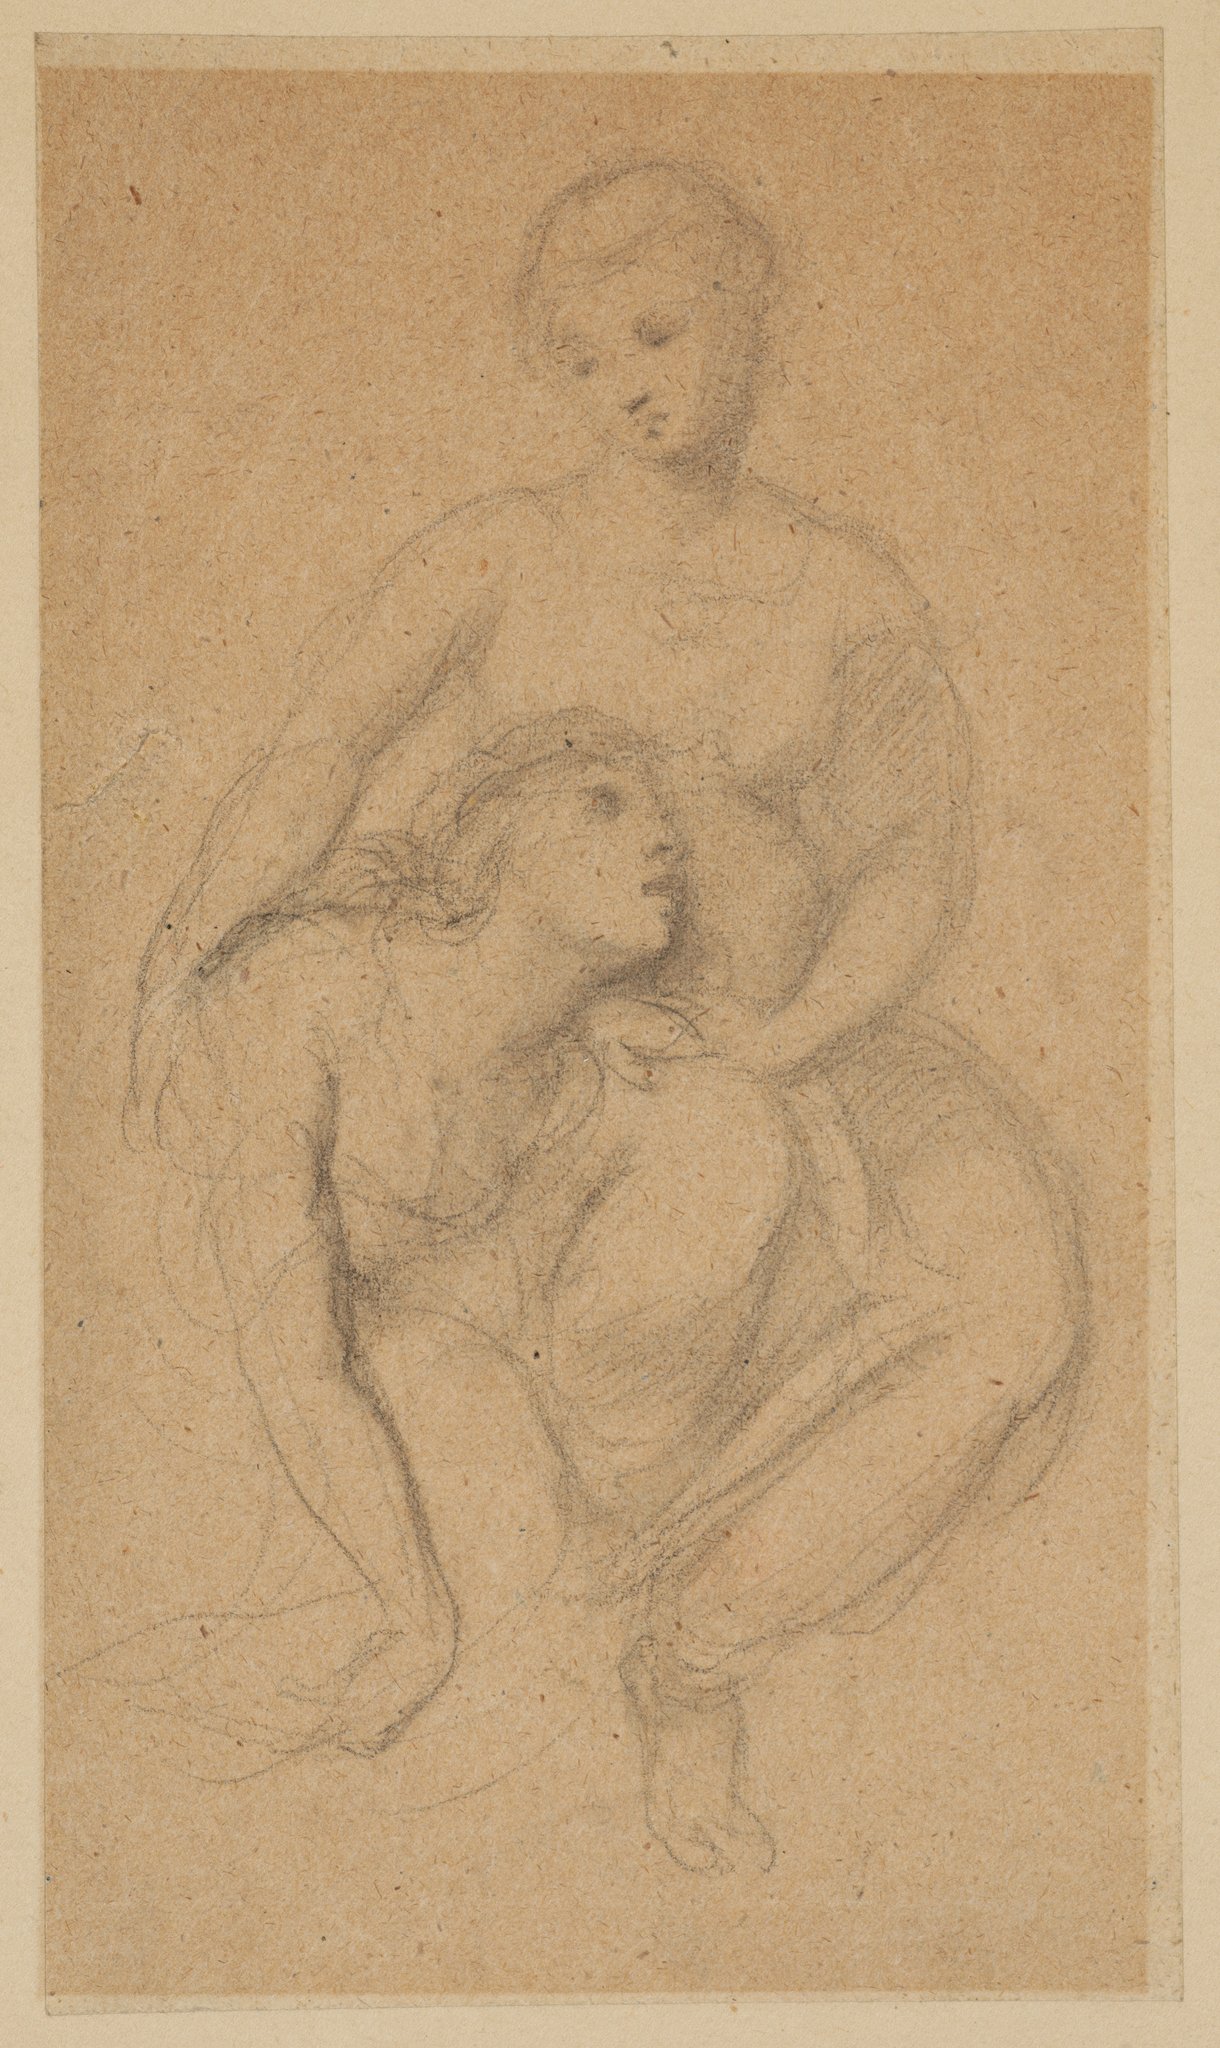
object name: drawing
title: Antigone & Ismene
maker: alfred george stevens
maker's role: artist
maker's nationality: british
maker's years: 1817-1875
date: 1833-1875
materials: chalk, paper